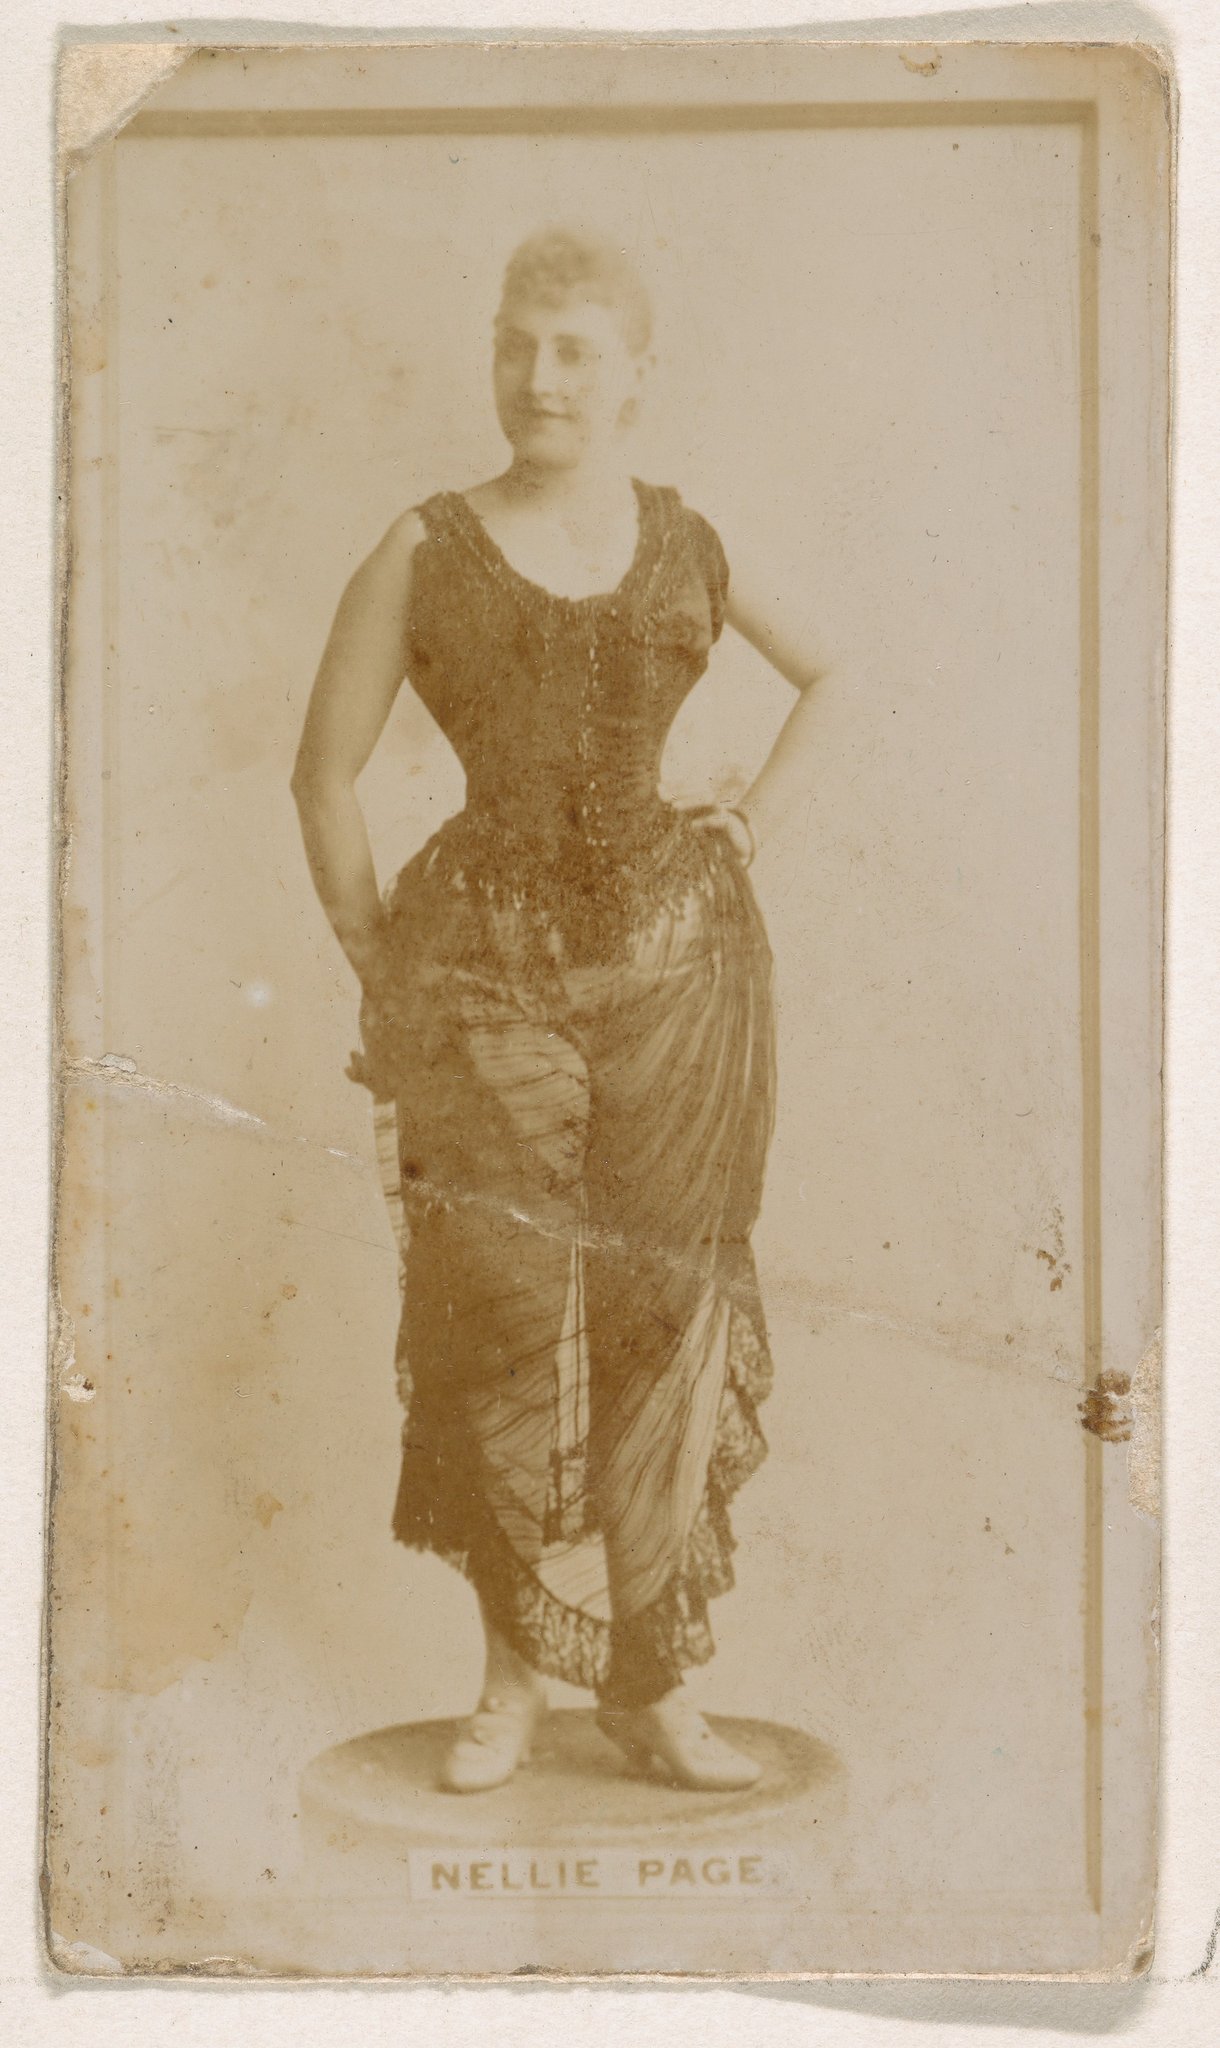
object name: photograph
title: Nellie Page, from the Actresses series (N245) issued by Kinney Brothers to promote Sweet Caporal Cigarettes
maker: kinney brothers tobacco company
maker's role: publisher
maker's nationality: american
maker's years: 1869-2011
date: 1890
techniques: albumen silver print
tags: portraits,women,actresses